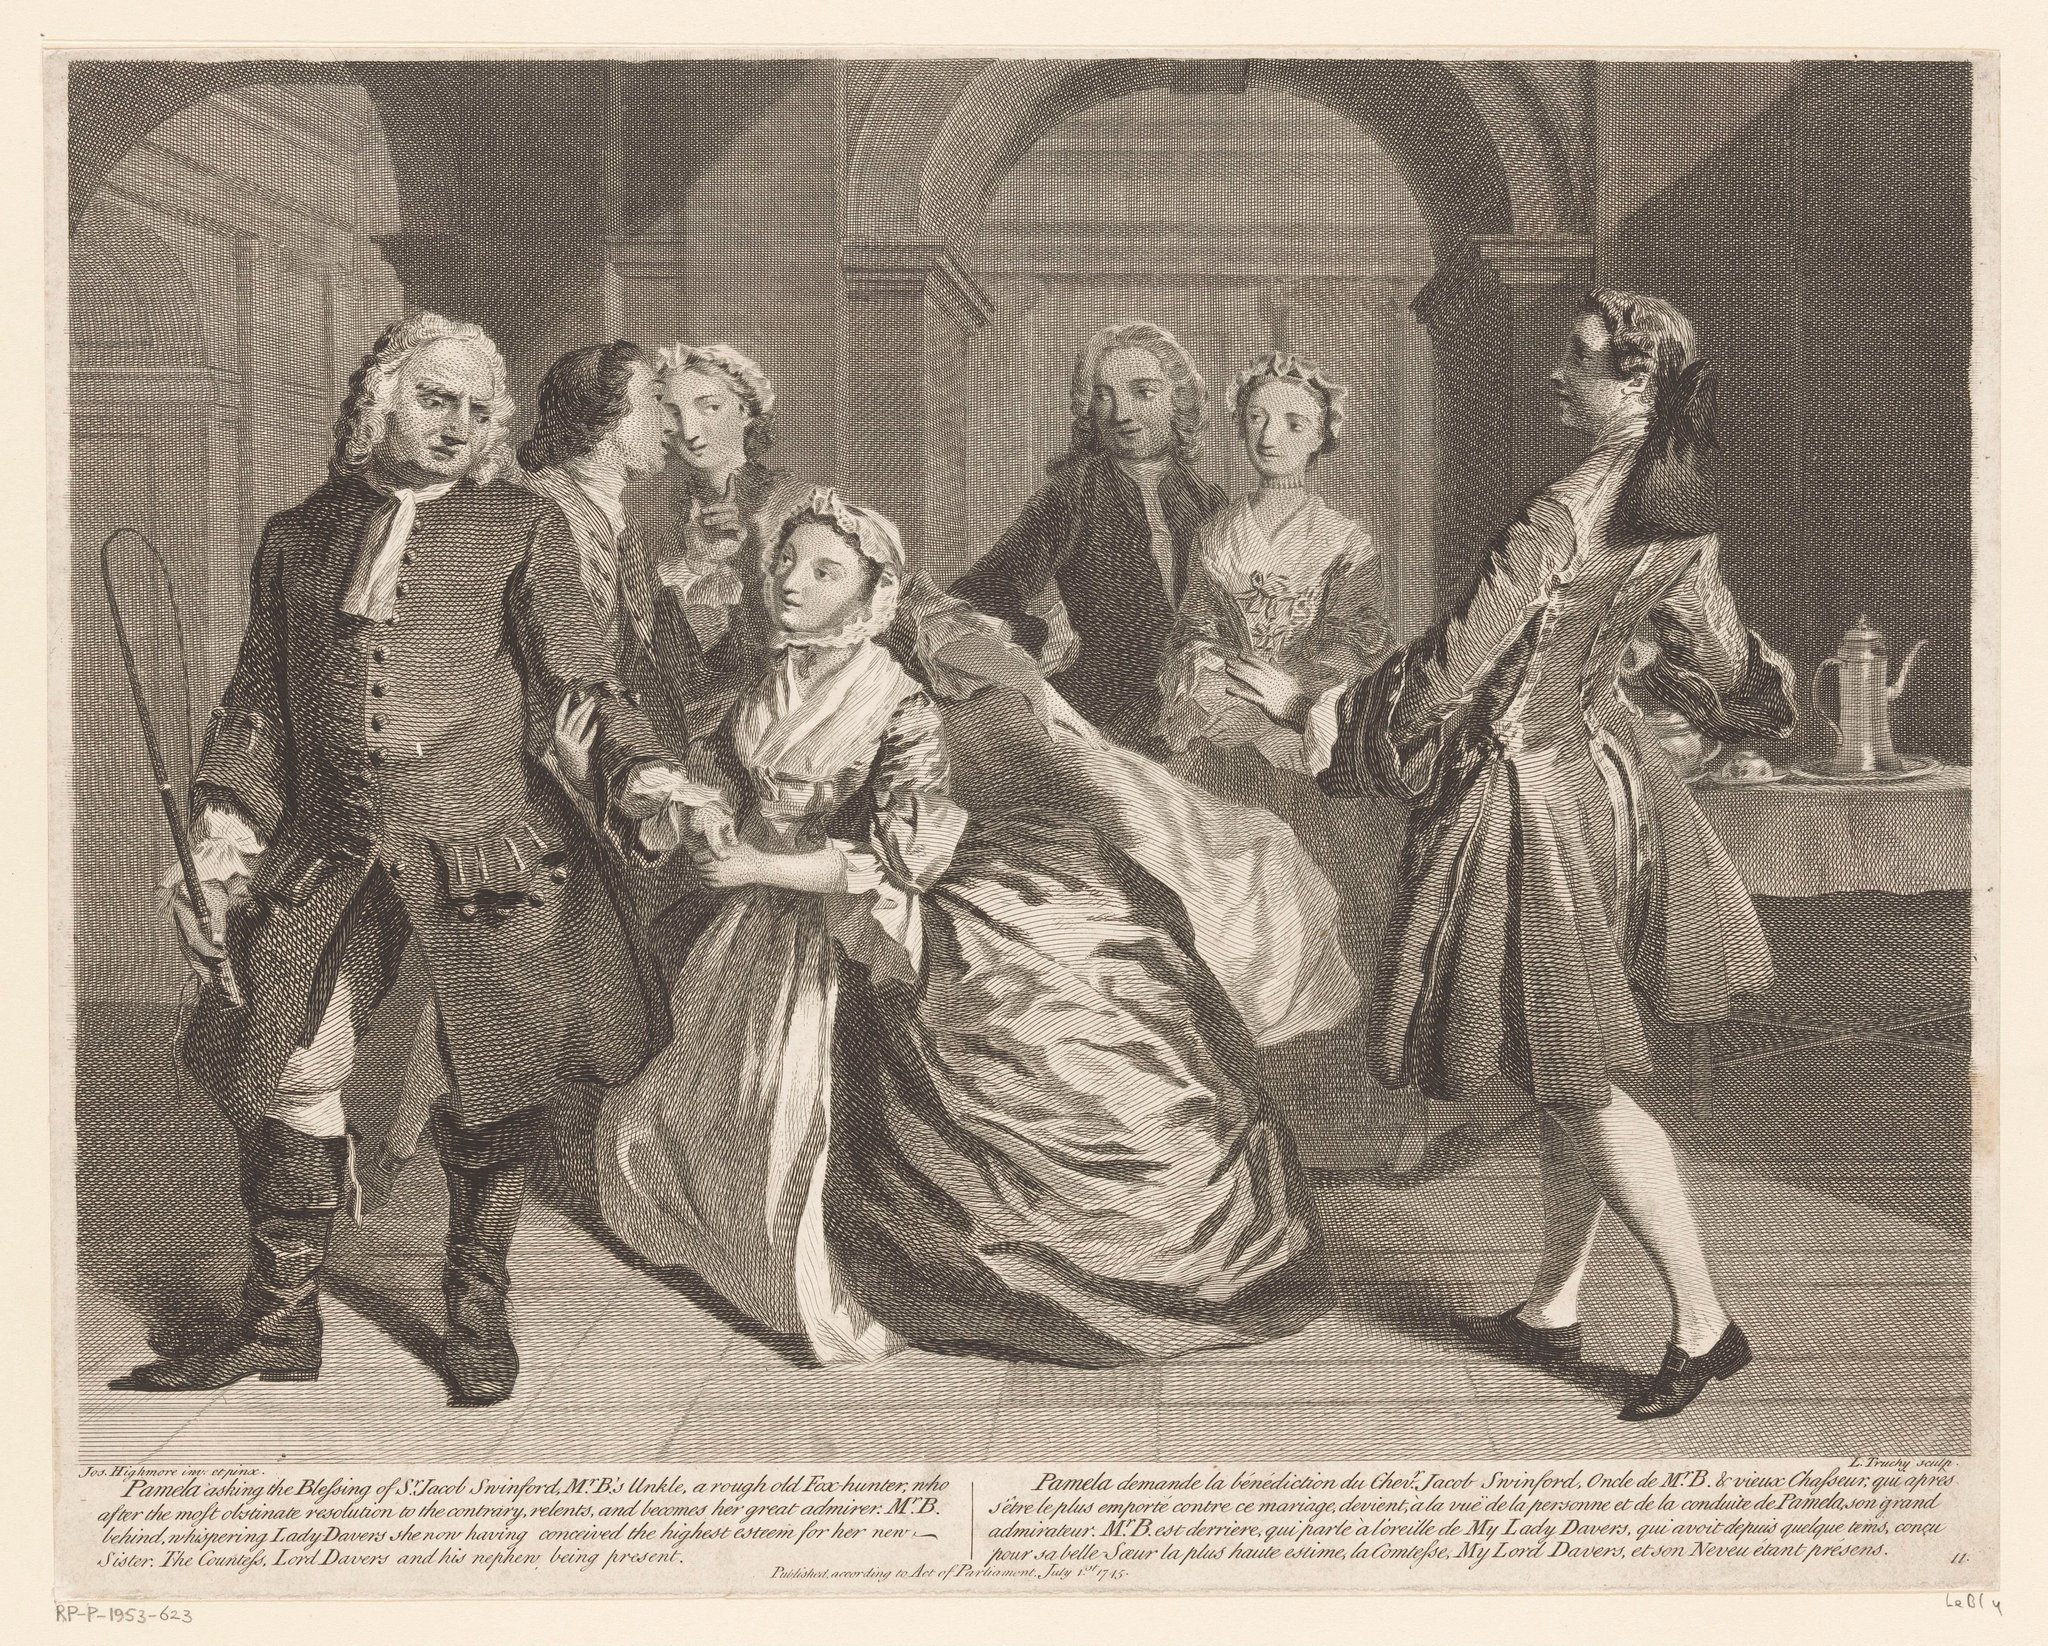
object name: print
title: Pamela, or; Virtue Rewarded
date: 1845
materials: paper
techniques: engraving, etching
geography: england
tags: pleading, interior of the house, male literary characters (pamela)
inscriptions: date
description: Maakt deel uit van een serie van twaalf prenten naar schilderijen door Joseph Highmore uit 1744, gebaseerd op de Engelse zedenroman "Pamela, or; Virtue rewarded" geschreven door Samual Richardson en gepubliceerd in 1740-1741. Pamela is een jonge dienstbode die in haar brieven haar ouders op de hoogte houdt van haar avonturen. Als haar meesteres sterft komt ze onder de hoede van de zoon des huizes, graaf Belfart, die haar vergeefs probeert te verleiden. Uiteindelijk trouwt hij haar alsnog.